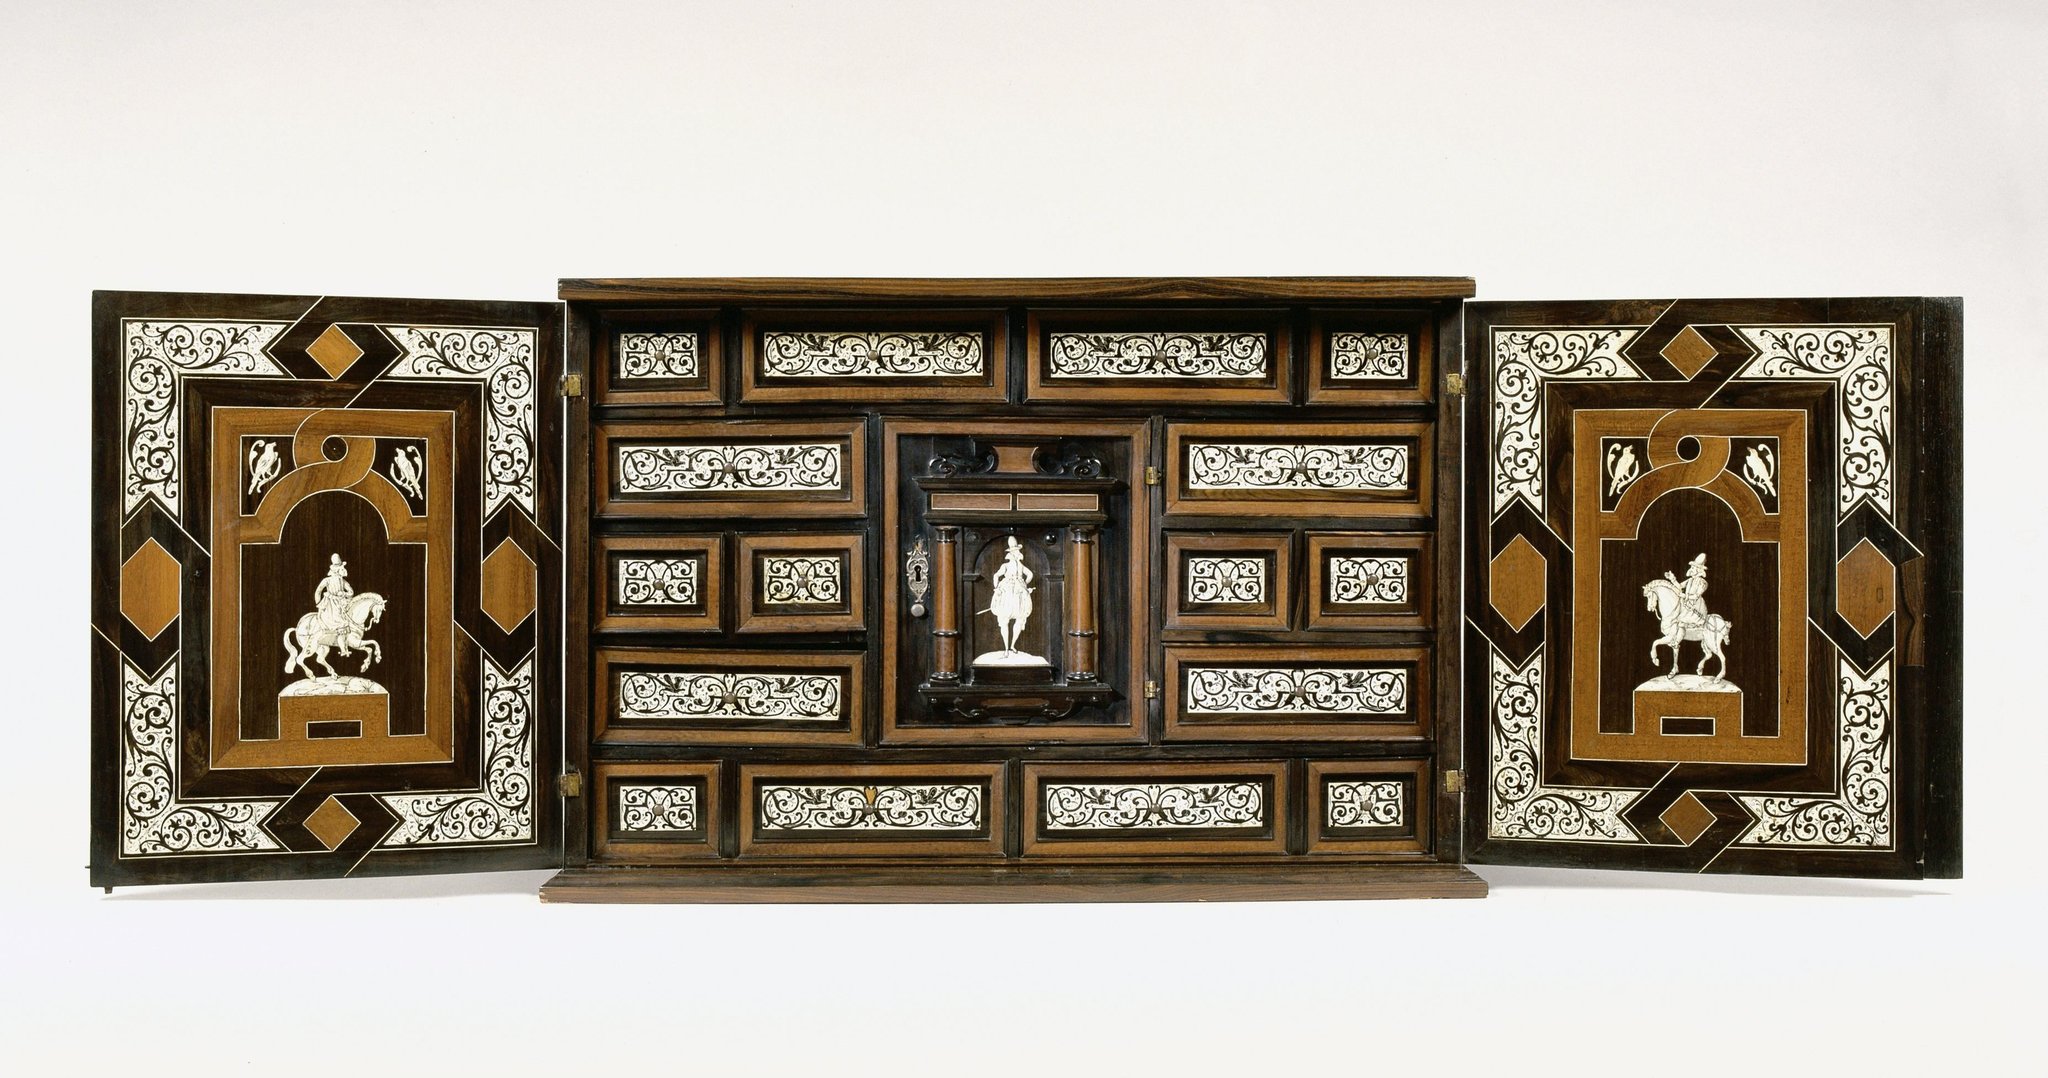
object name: collector's cabinet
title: Kunstkast belijmd met palissander- en ebbenhout en ivoor op een grenenhouten kern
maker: Anonymous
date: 1620-1630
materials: brass, wood, ivory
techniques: marquetry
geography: augsburg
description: Cabinet. Pine and oak, veneered with ebony, coromandel, snakewood and ivory. Probably Augsburg, c. 1620-1630. Gift of Miss J.G. Fontein from the estate of Mrs. J.R. Wüste, 1924.